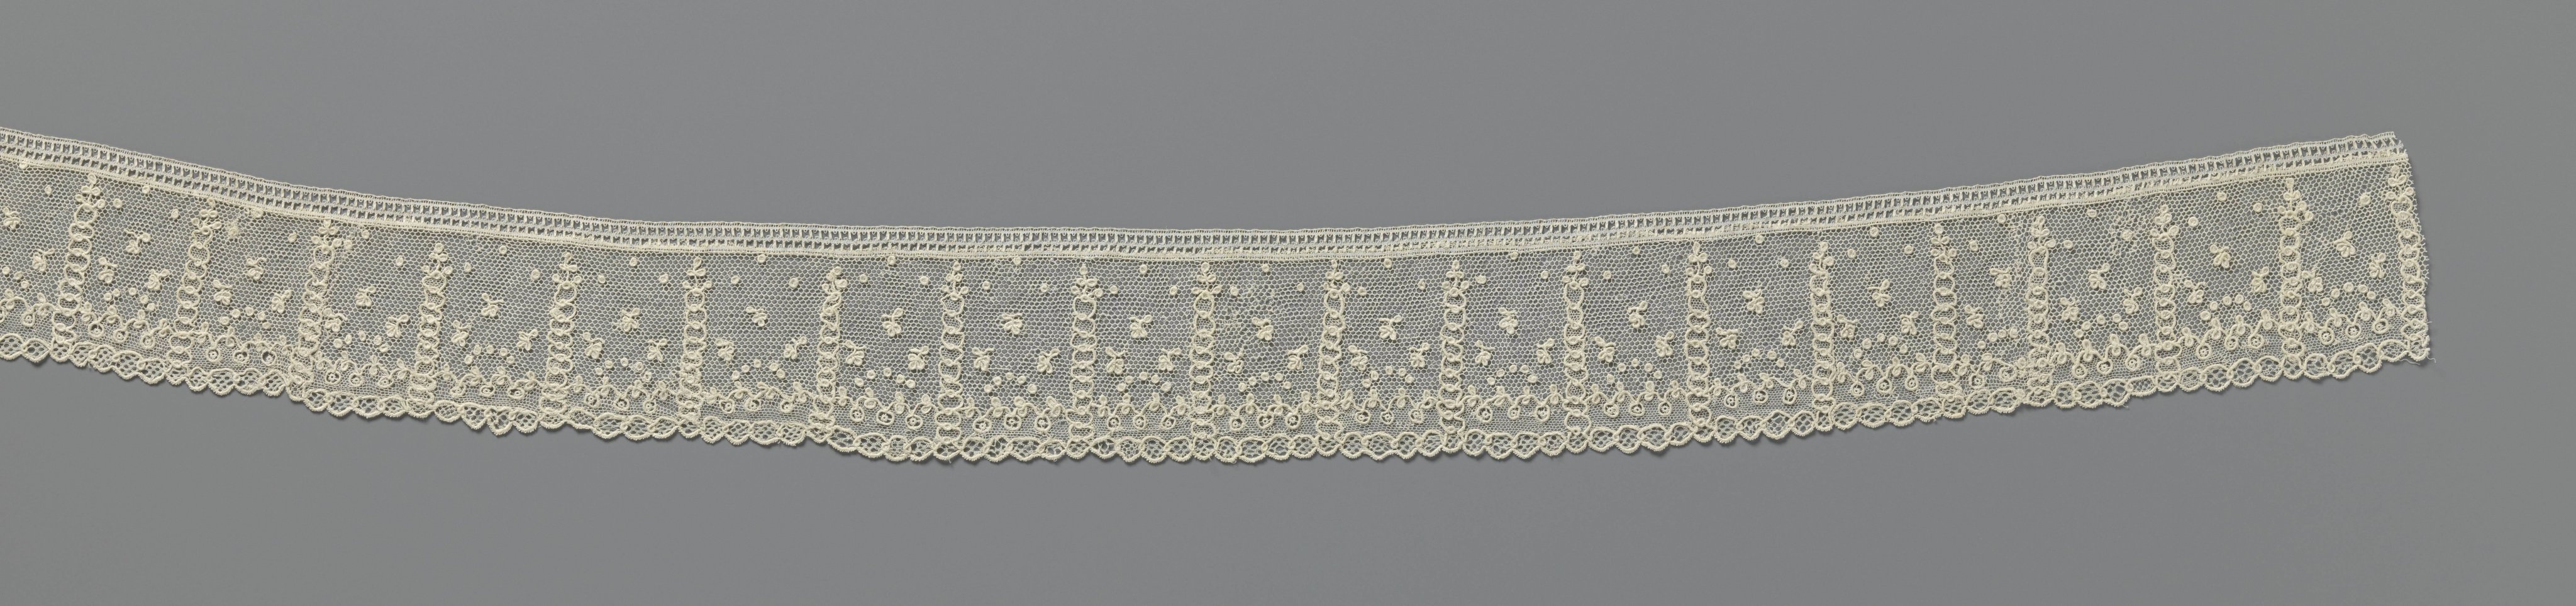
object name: strip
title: Strook naaldkant met dubbele verticale spiralen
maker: Anonymous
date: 1775-1795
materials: linen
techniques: lace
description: Strook naturelkleurige naaldkant: Alençon-kant. Repetitief motief van dubbele verticale spiralen en een strooimotief van bloemen en stippen op een fijne zeshoekige maasgrond. Een horizontaal kronkelende lijn met strikjes en cirkeltjes loopt op ongeveer driekwart van de bovenrand door het patroon heen. De bovenzijde is afgezet met een rand kloskant. De onderrand wordt gevormd door een horizontale spiraal met daaronder een gepicoteerde boogjesrand. De ruimte tussen de spiraal en de boogjes is opgevuld met een siergrond.